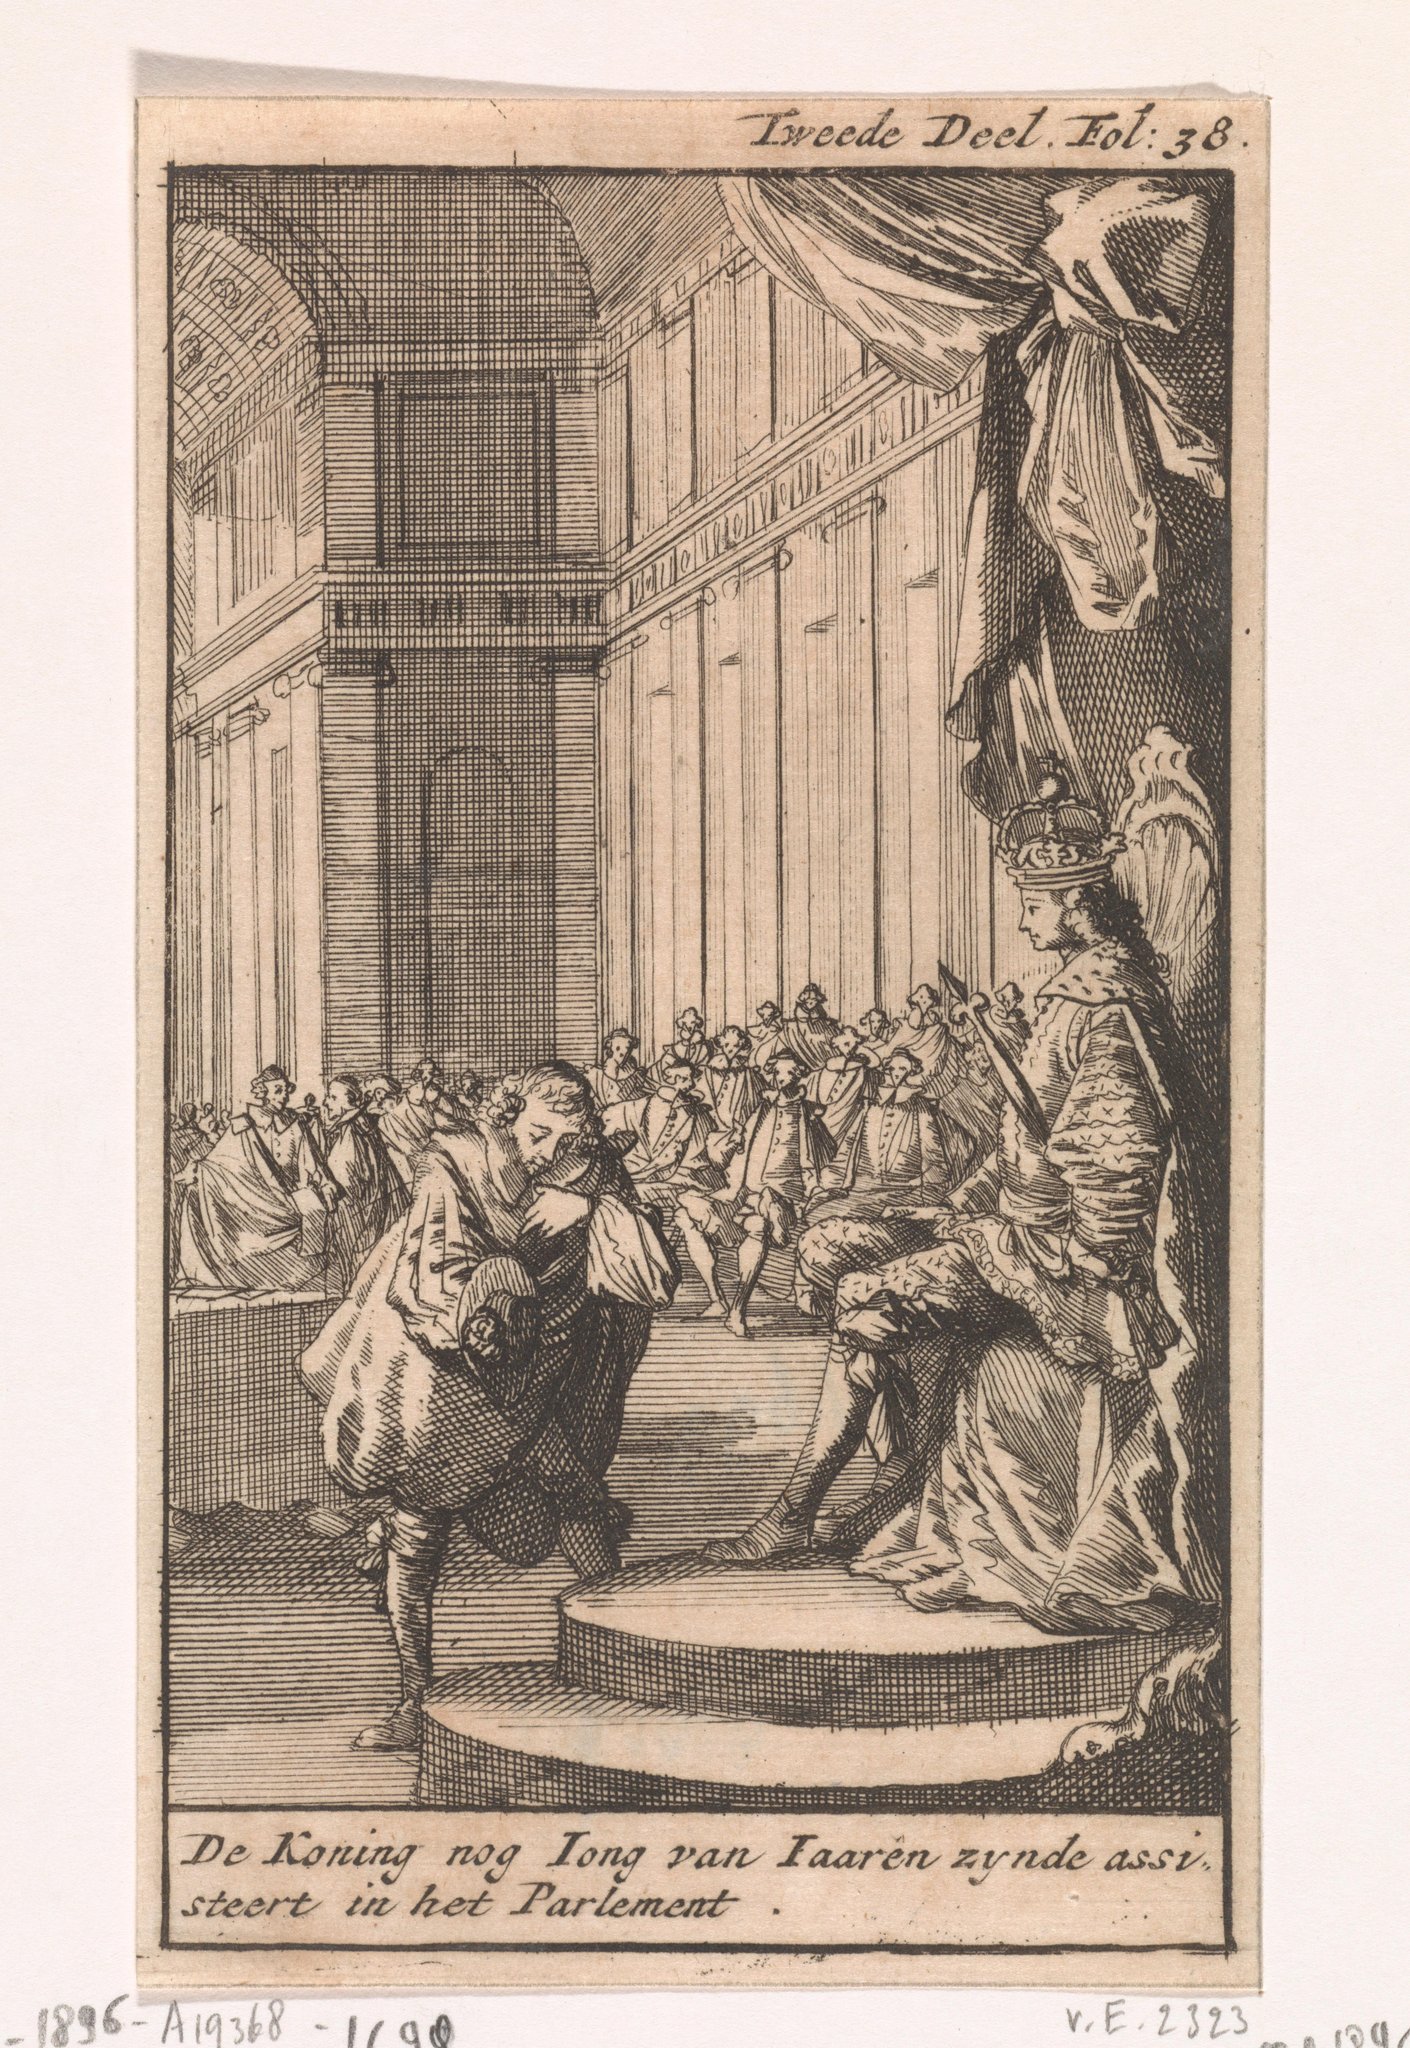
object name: print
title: Hoveling buigt voor de jonge Lodewijk XIV van Frankrijk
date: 1699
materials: paper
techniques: etching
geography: leiden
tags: lodewijk xiv (koning van frankrijk), throne-room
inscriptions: collector's mark: Lugt 2228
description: Boekillustratie voor Het leven en bedryf van den wytberoemden en grooten staatkundigen Julius Mazaryn. Leiden: Boudewijn van der Aa, 1699, dl. 2, f. 38.